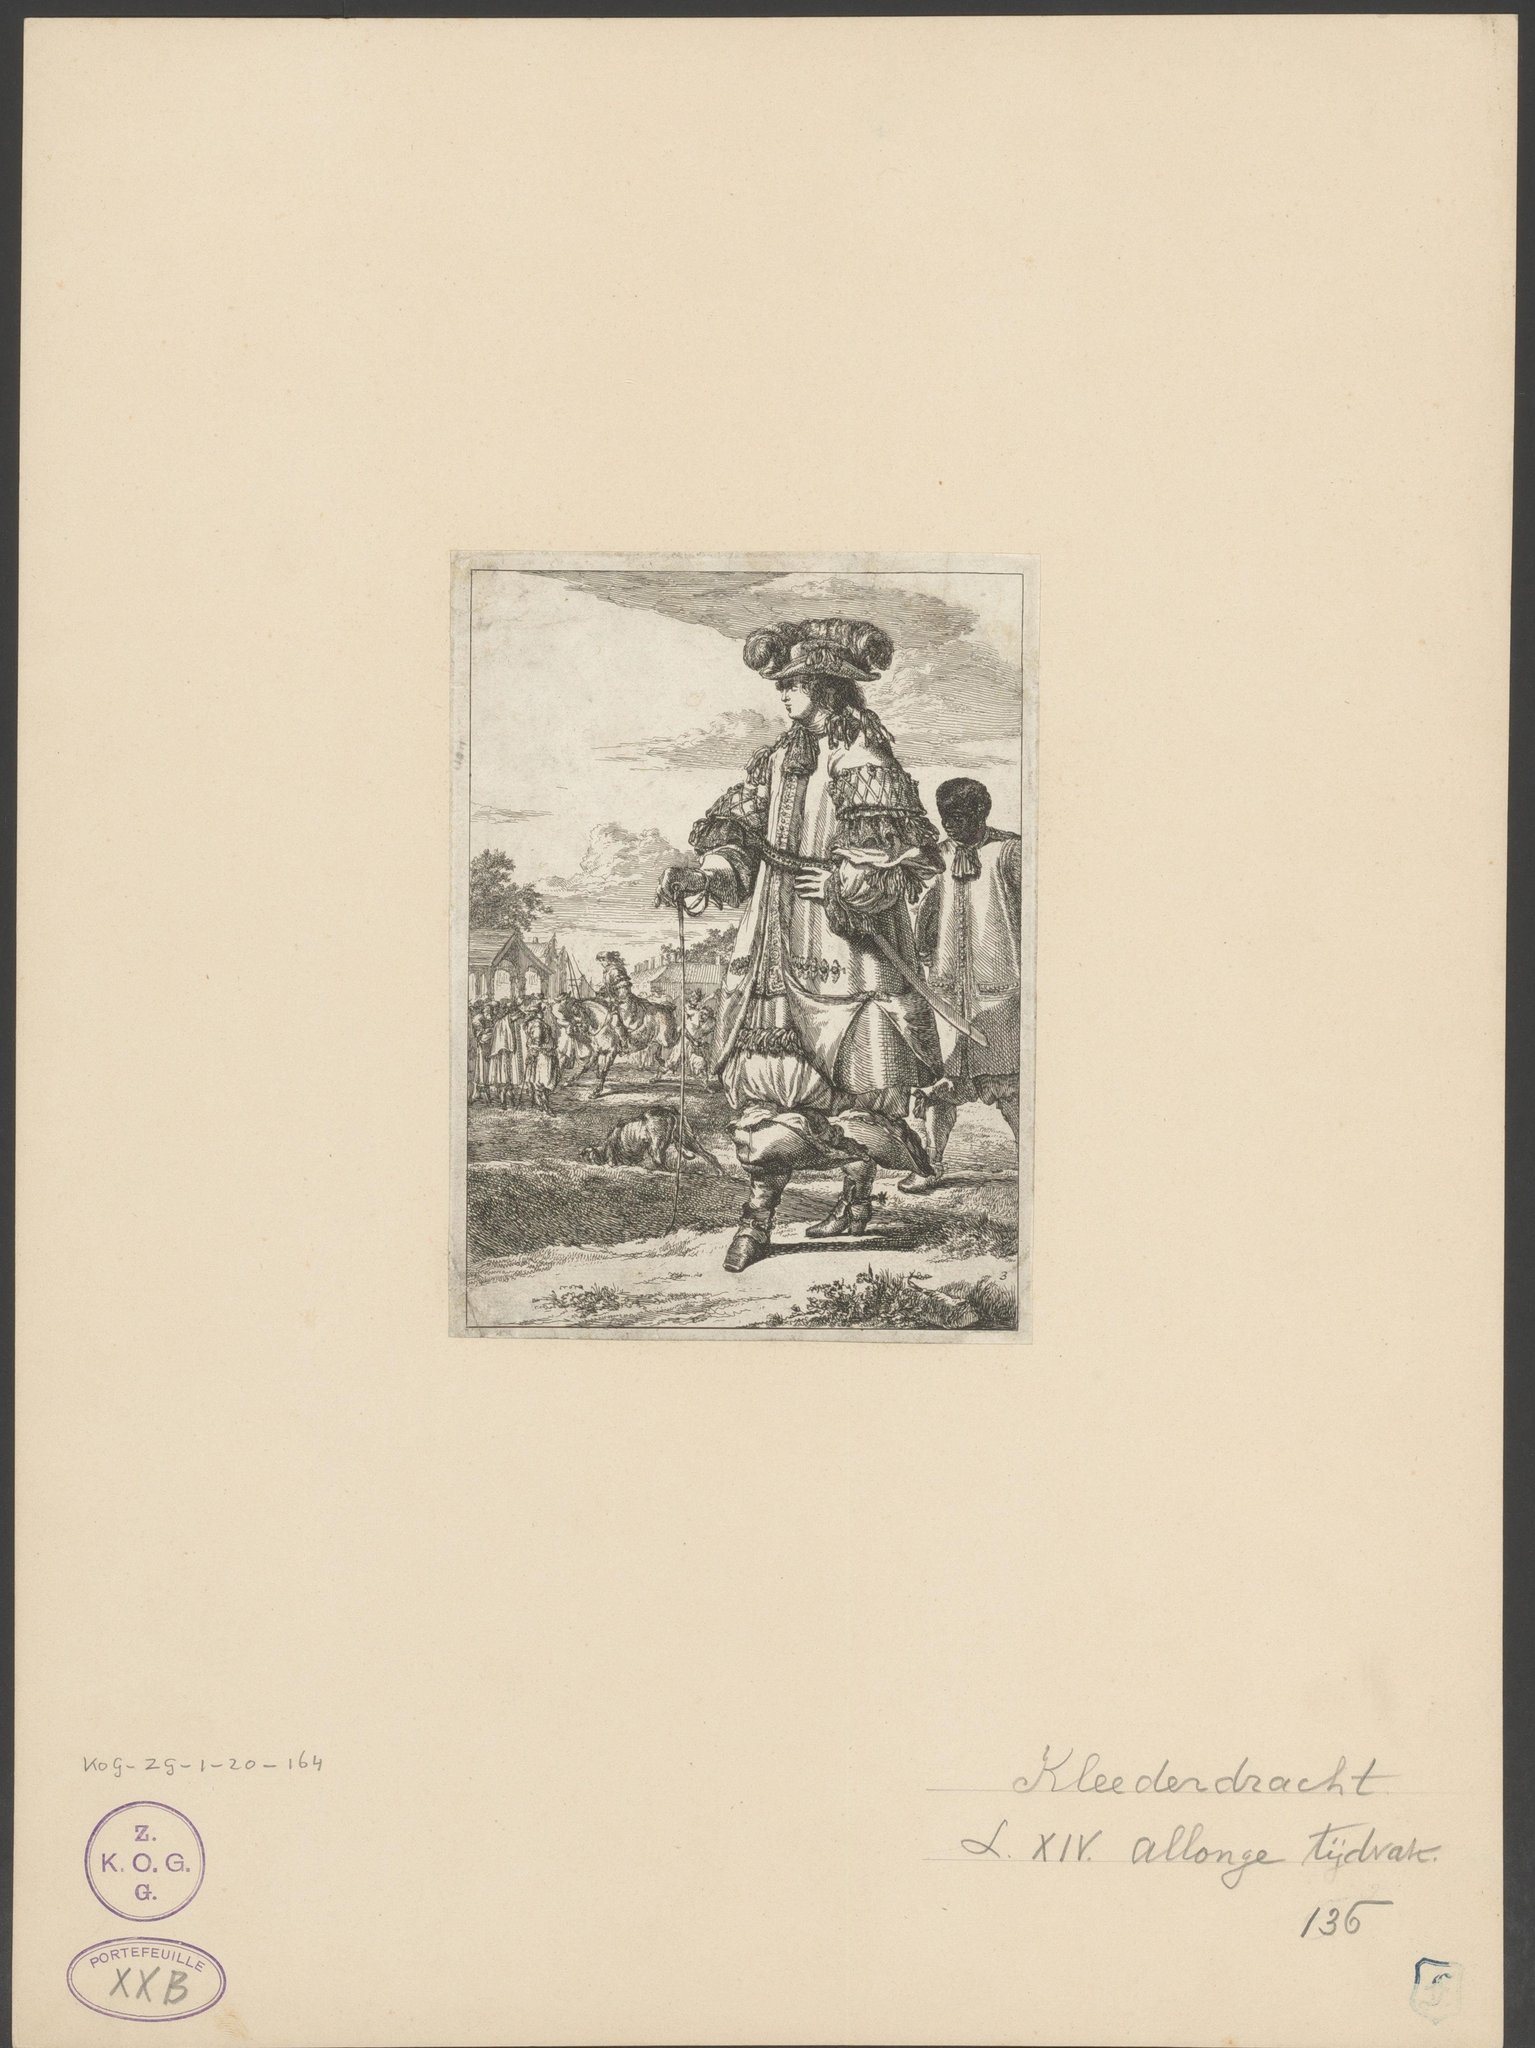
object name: print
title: Elegant geklede heer met Afrikaanse bediende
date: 1662-1702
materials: paper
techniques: etching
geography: amsterdam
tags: coat (+ men's clothes), africans, head-gear: hat (+ men's clothes), shoes, sandals (+ men's clothes), trousers, breeches, etc. (breeches) (+ men's clothes), clothes, costume, head-gear: hat (+ feathers used for clothes), walking-stick, staff, cane (+ men's clothes), manservant, footman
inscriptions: collector's mark: Lugt 1641, stamp, collector's mark: Lugt 963, collector's mark: Lugt 963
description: Modieus geklede man in rijk gedecoreerde lange jas tot over de knieën (rock) over een vest. Wijde, poffende kniebroek en laarzen met wijde schachten (canons). Hoed met pluimen op het hoofd, een rijzweep in de rechterhand, schoenen met hakken en sporen. Achter hem een jonge Afrikaanse bediende. Ruiters op de achtergrond. Onderwerpsrubrieken binnen de Atlas Zeden en Gewoonten: Zeden en Gewoonten in Engeren Zin, De Kleeding, Kleederdrachten (tijdvakken), Lodewijk XIV (1650 – 1720). Het allonge tijdvak).